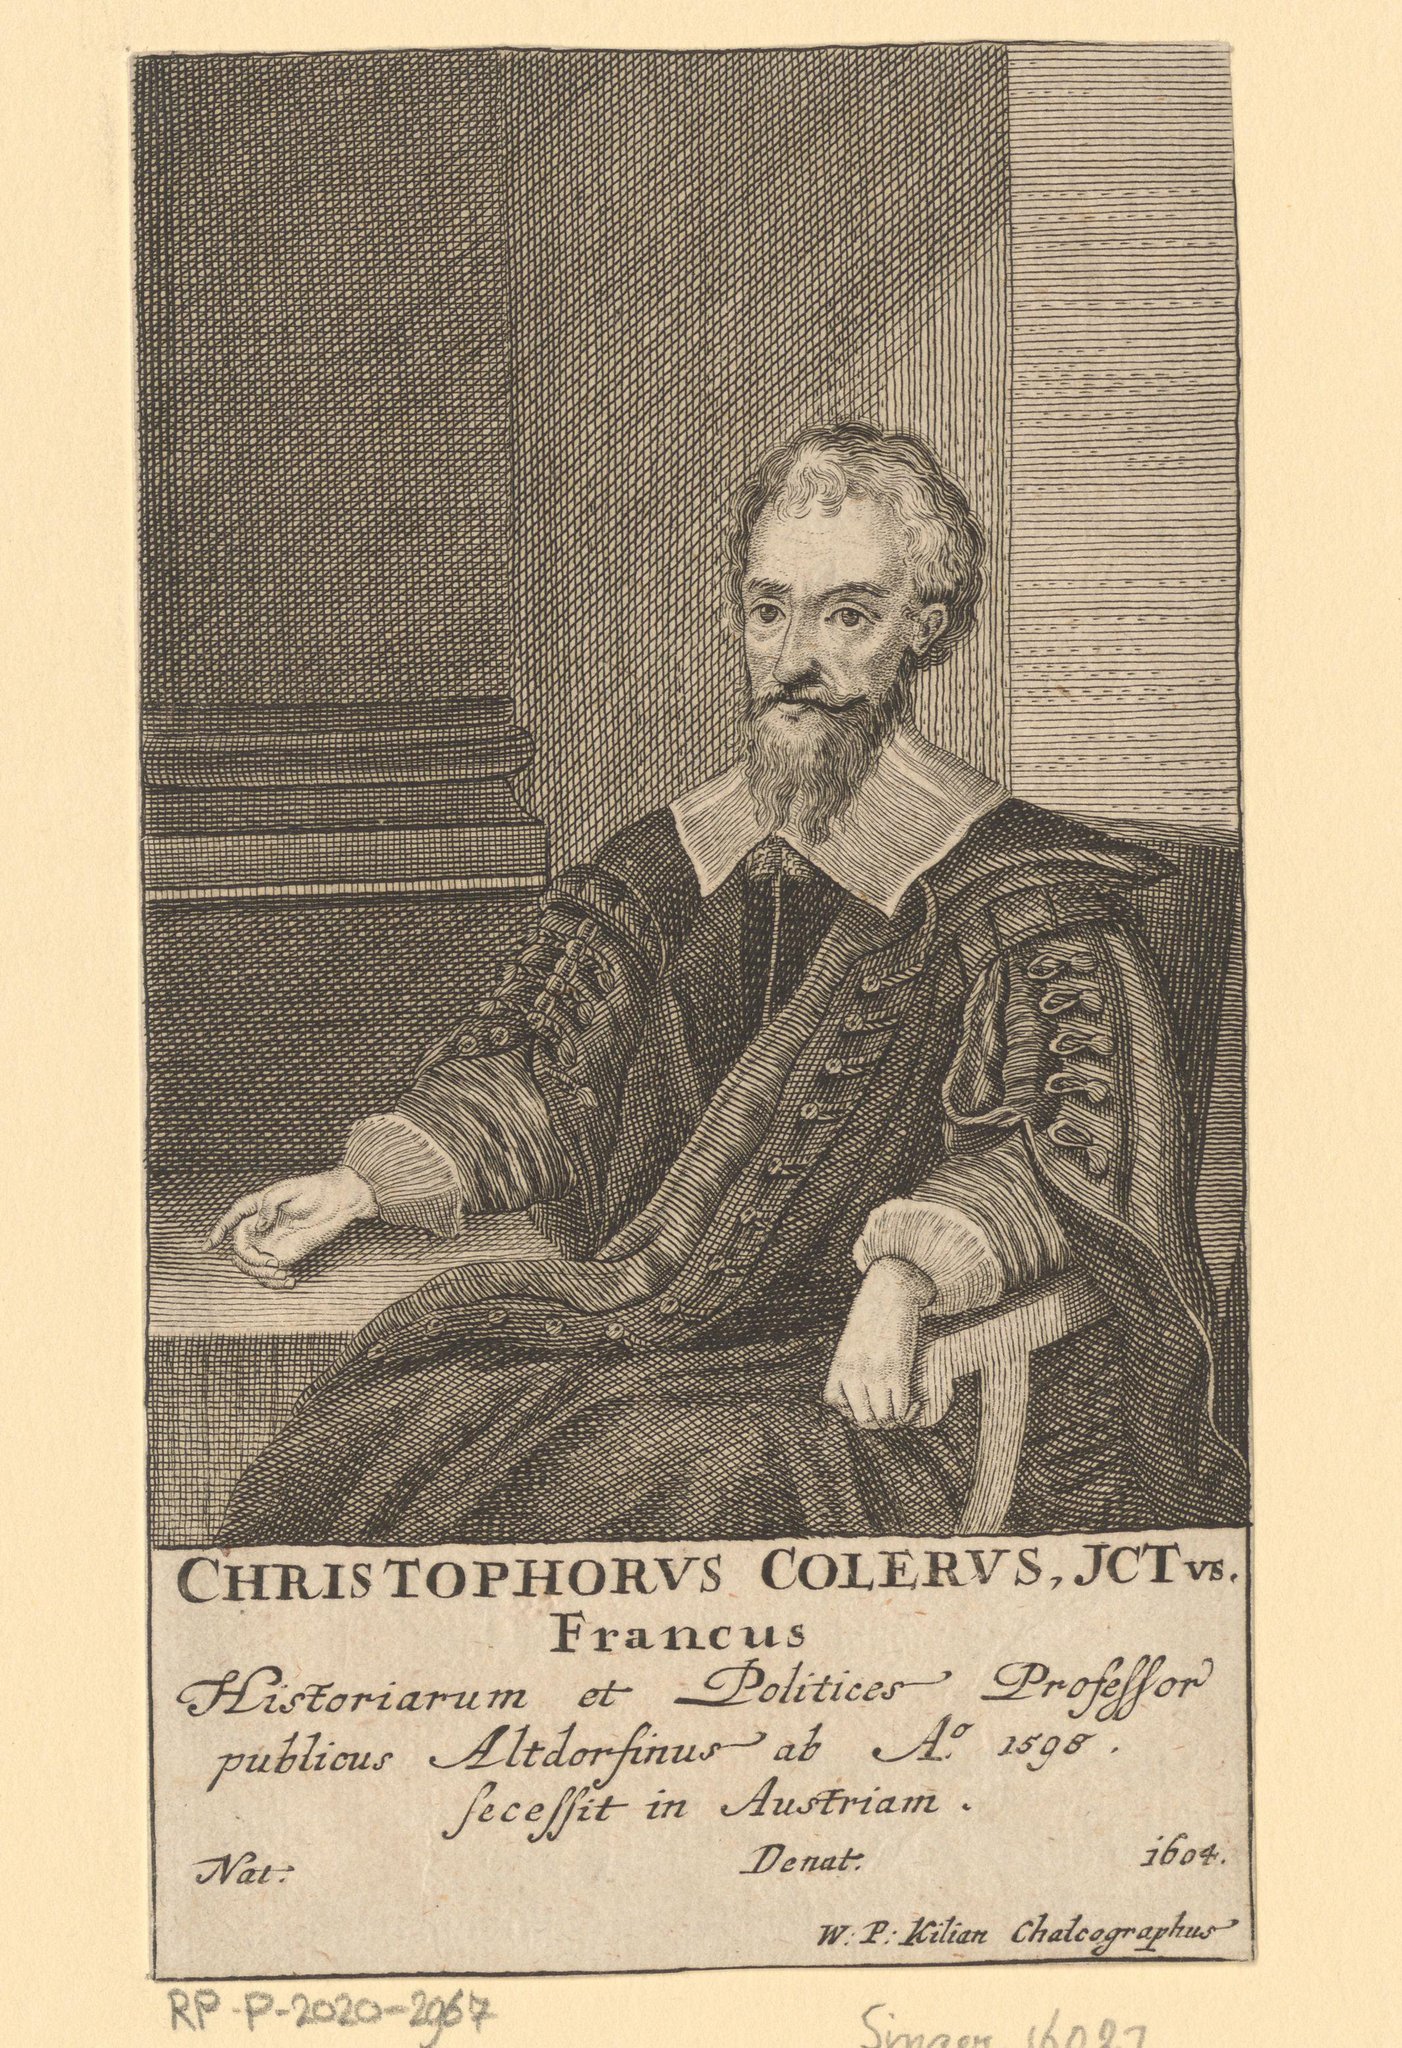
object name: print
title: Portret van Christoph Coler II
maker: wolfgang philipp kilian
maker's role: artist, draughtsman, print maker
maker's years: 1654-1732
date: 1721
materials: paper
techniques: engraving, etching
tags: politician, historical persons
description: Prent mogelijk uit: Rothscholtz, Friedrich. Eruditorum academiae Altdorfinae. Neurenberg en Altdorf: erven Johann Daniel Tauber, 1721.